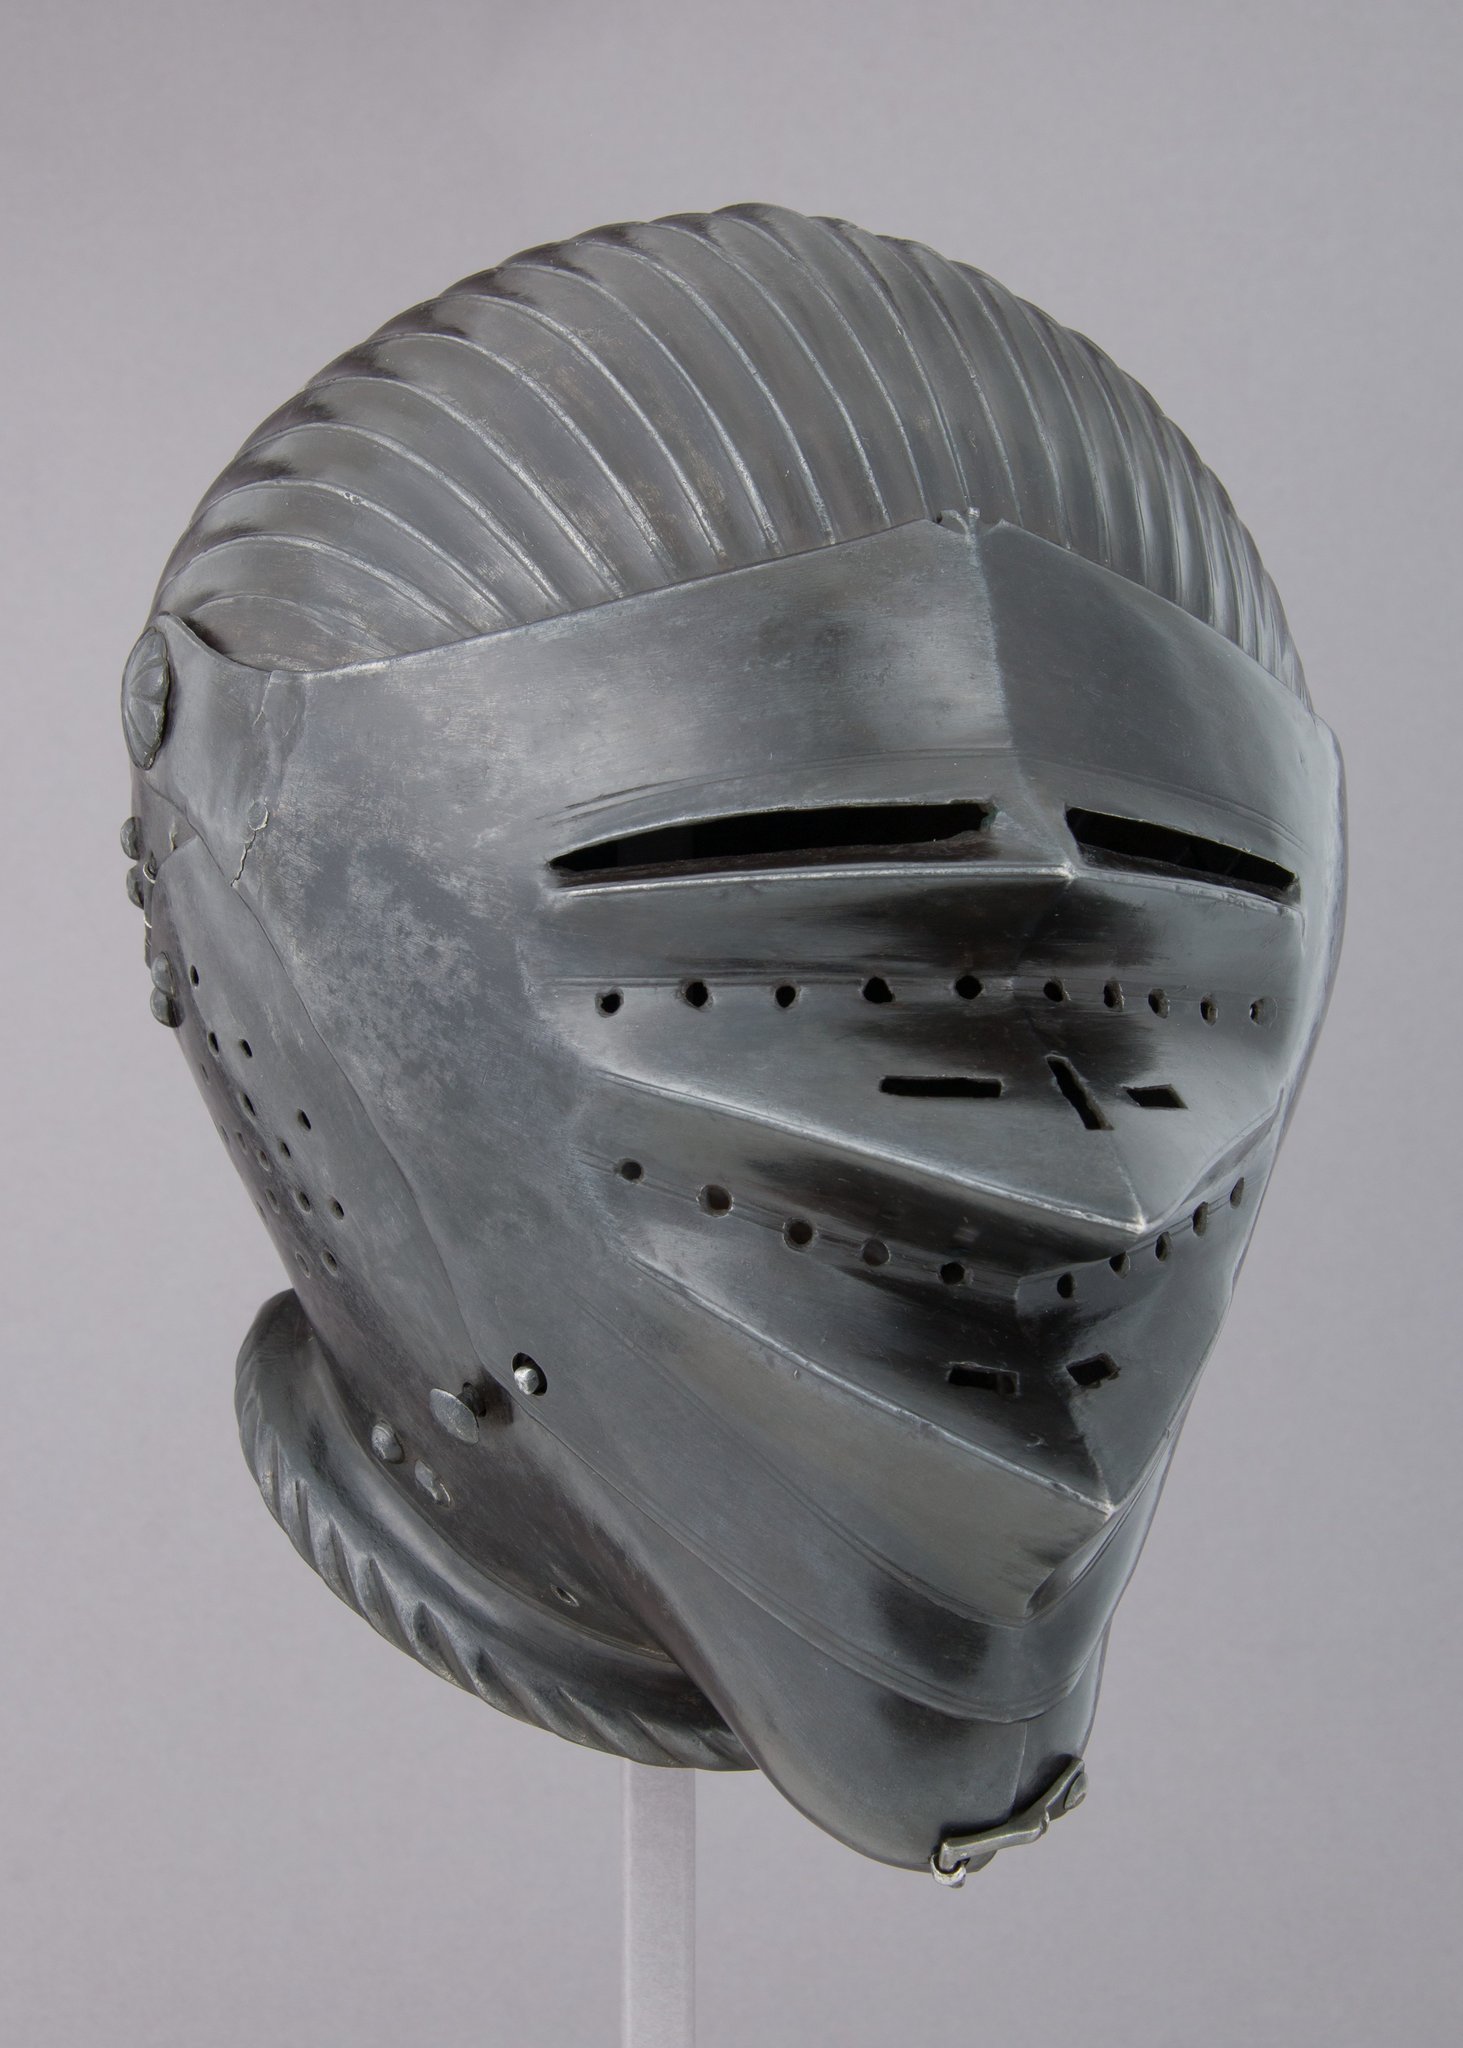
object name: maximilian armet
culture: german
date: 1525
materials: steel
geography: germany